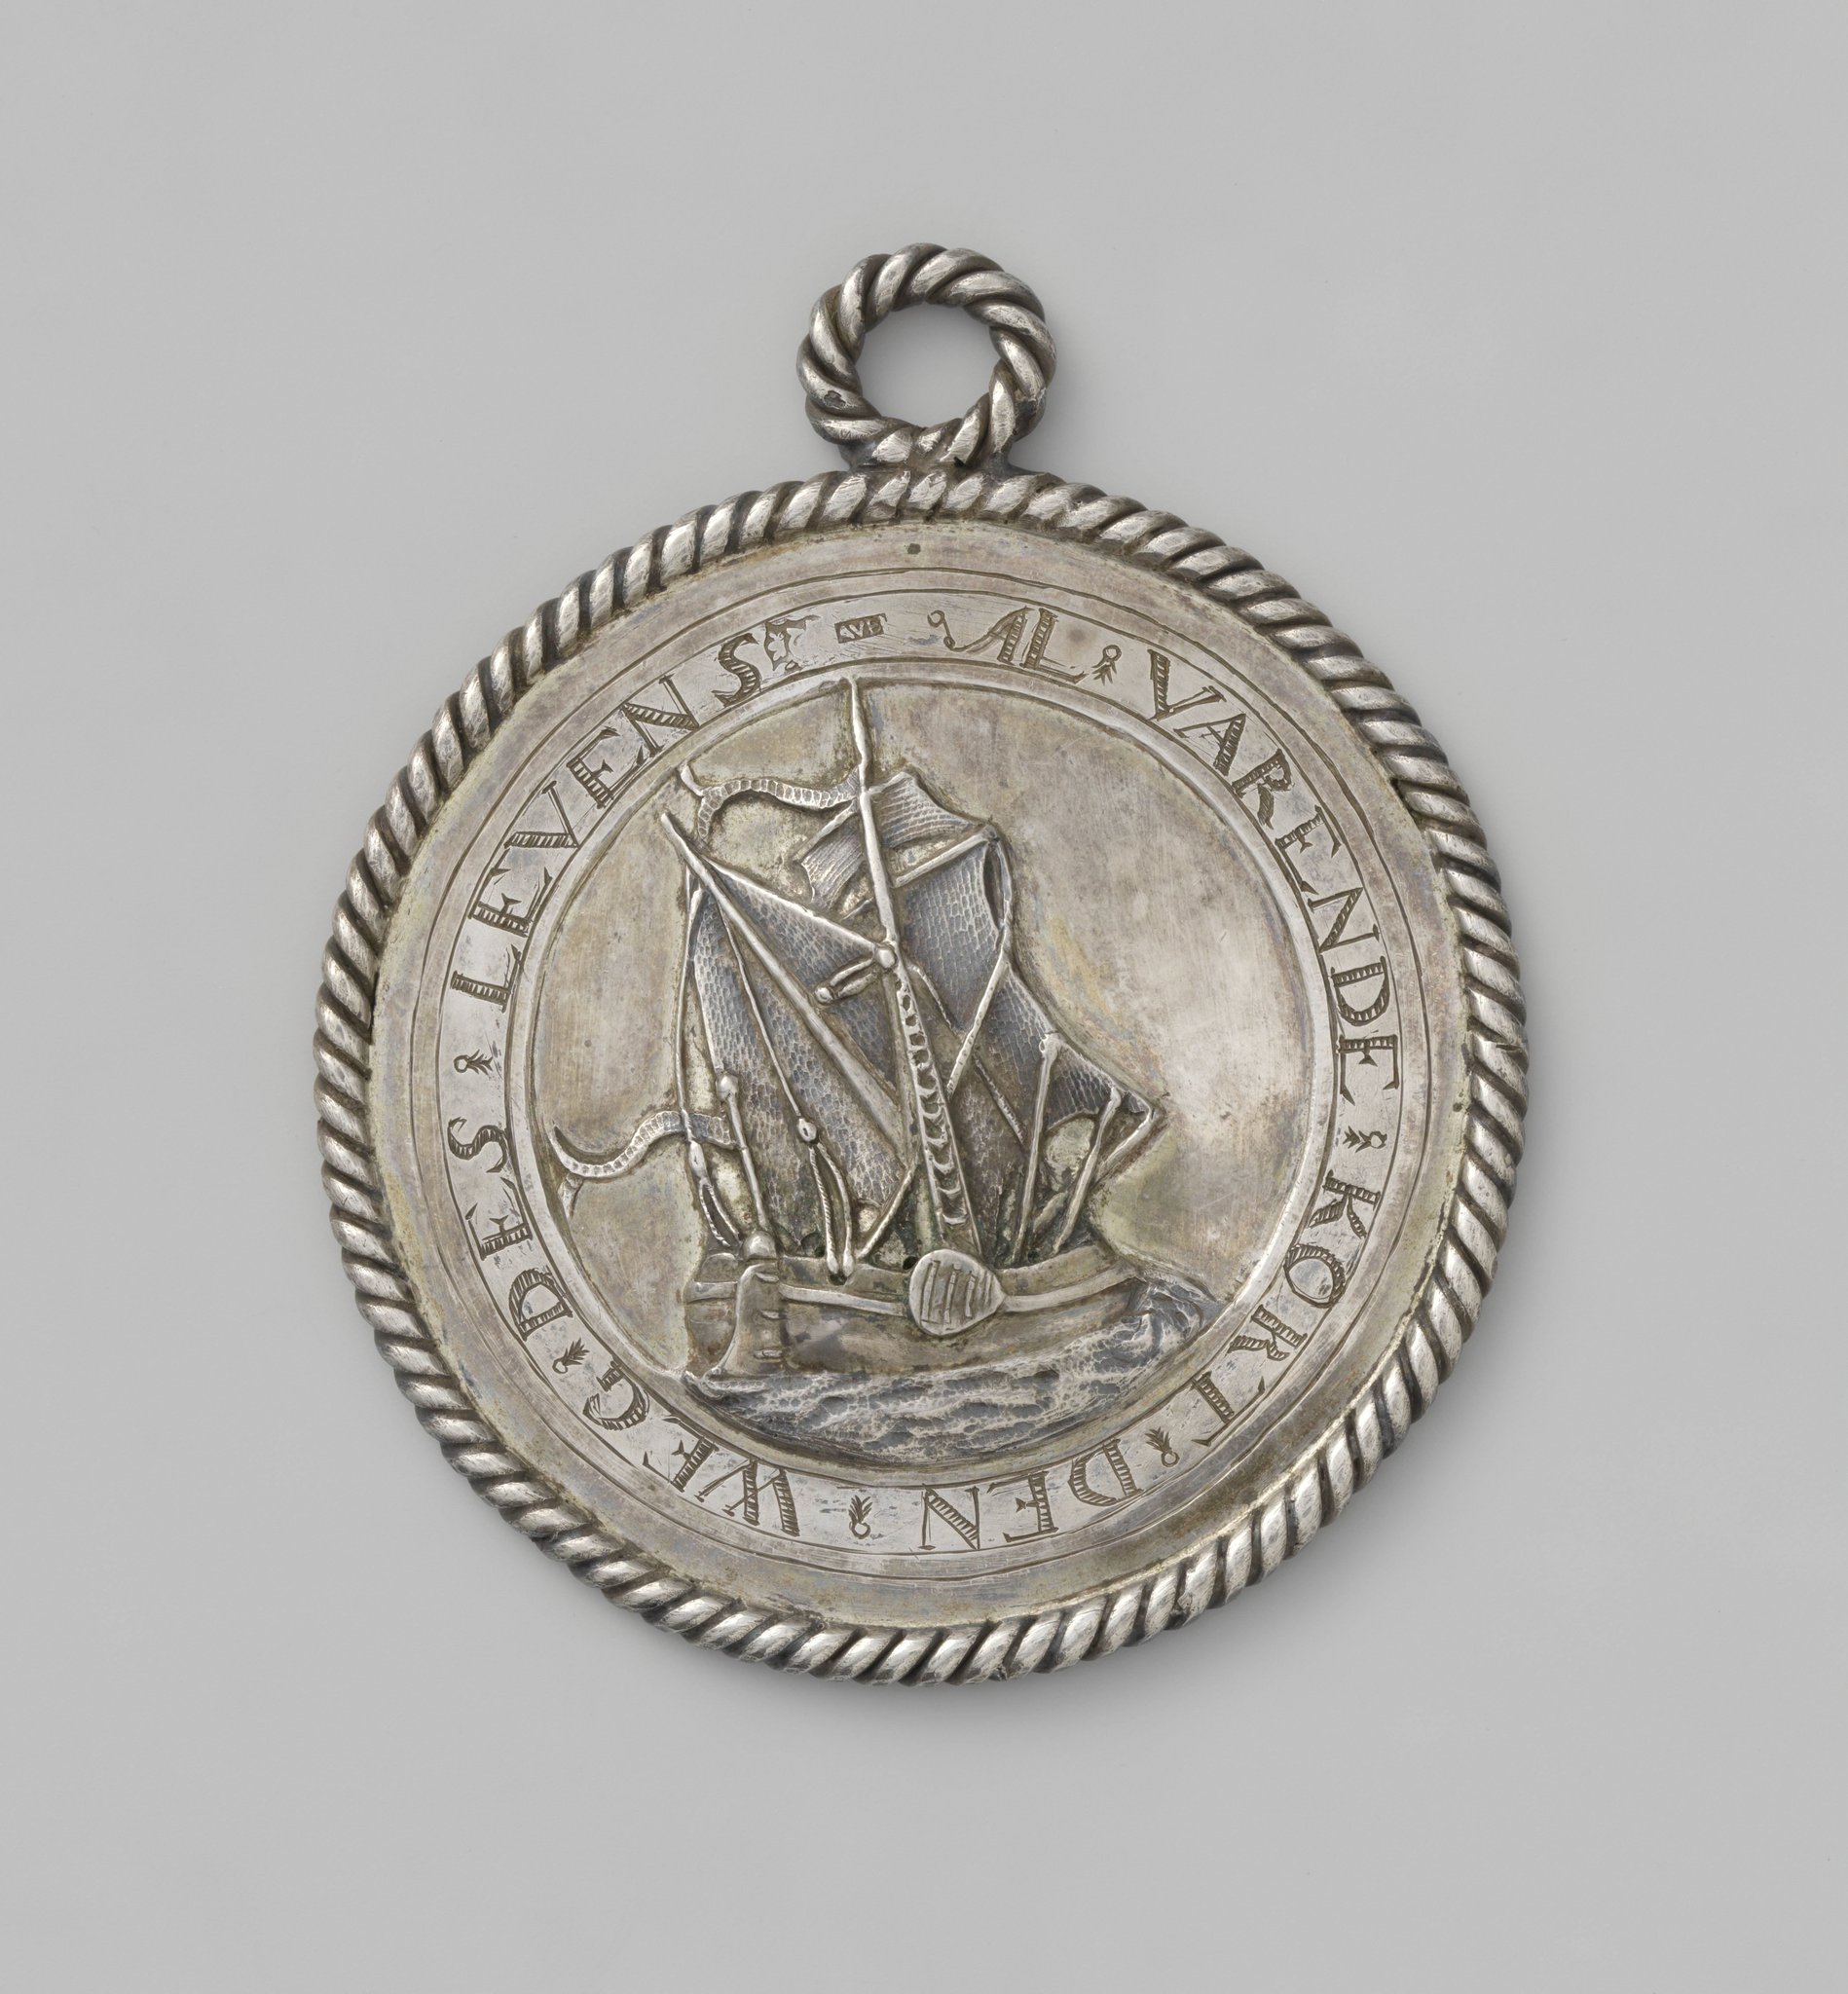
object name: medal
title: Den Bosch, Bargemen’s Guild, Honoring the Head Deans Claude Antoine Lormier and Willem Cornelis Ackersdyck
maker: andreas van beugen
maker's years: 1779-1781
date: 1780-1781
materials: silver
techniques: casting, engraving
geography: den bosch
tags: den bosch